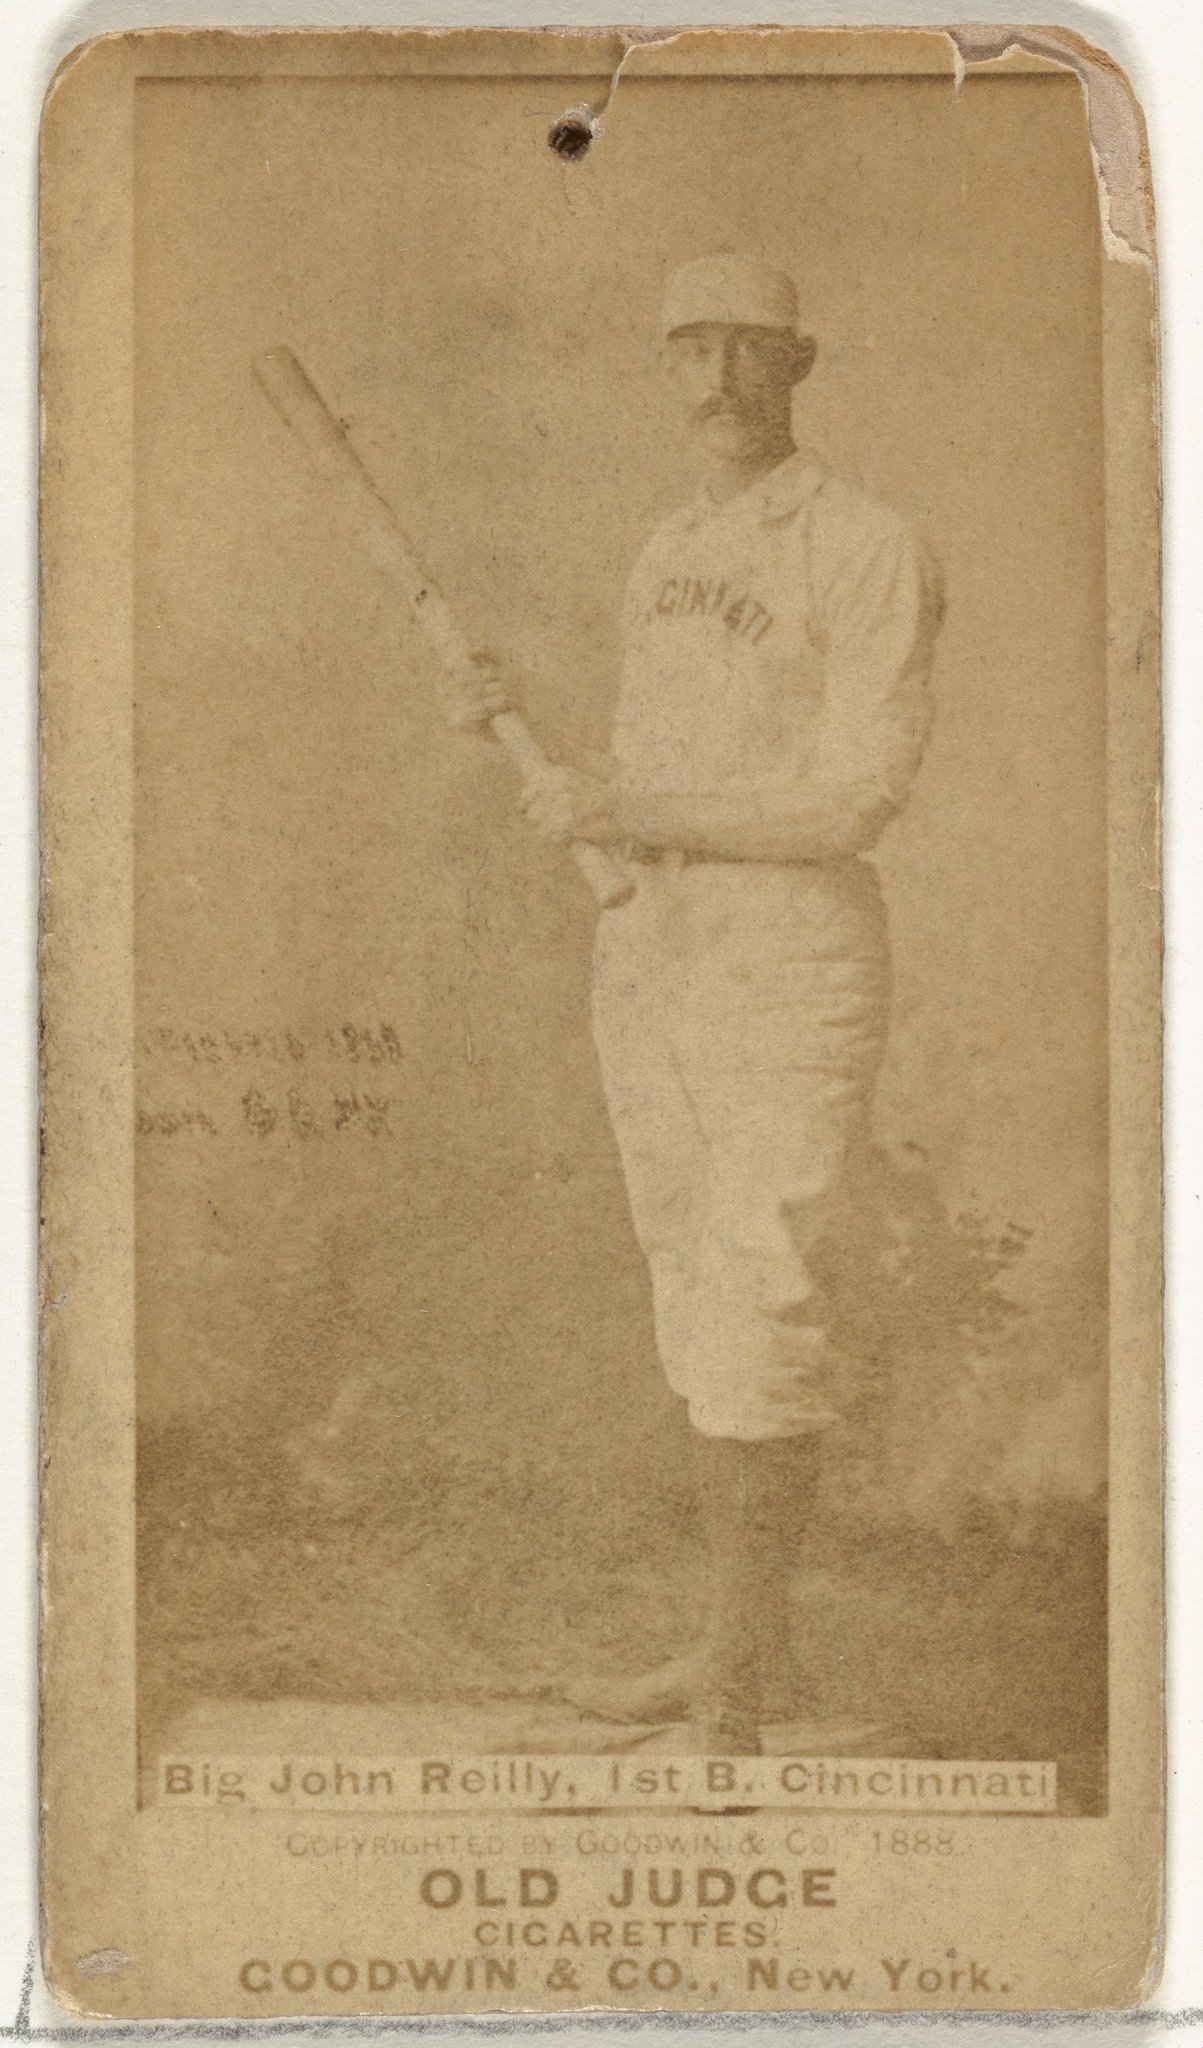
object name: baseball card, photograph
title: John Good "Long John" Reilly, 1st Base, Cincinnati, from the Old Judge series (N172) for Old Judge Cigarettes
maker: goodwin & company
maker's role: publisher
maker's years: 1850-1950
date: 1888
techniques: albumen silver print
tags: men,portraits,baseball,athletes